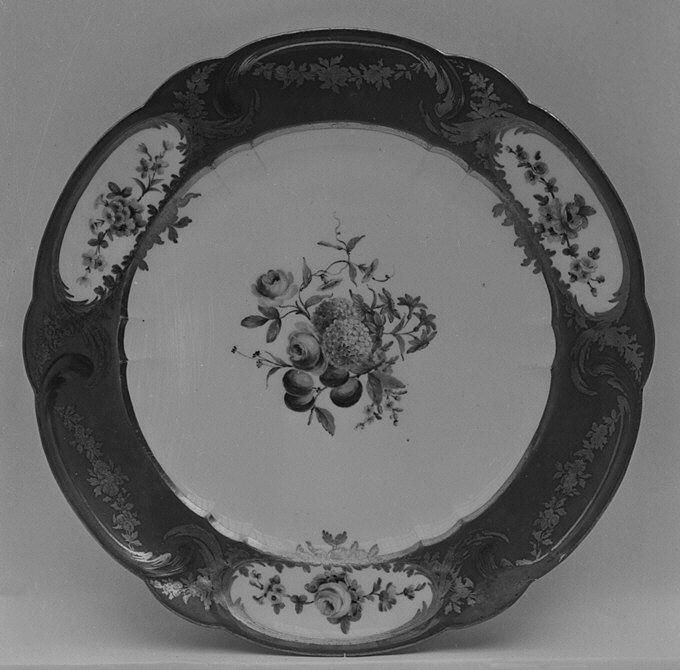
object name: plate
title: Plate (Assiette à palmes) (1 of 102) (part of a service)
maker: sèvres manufactory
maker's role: manufactory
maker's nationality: french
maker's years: 1740-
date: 1786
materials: soft paste porcelain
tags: flowers